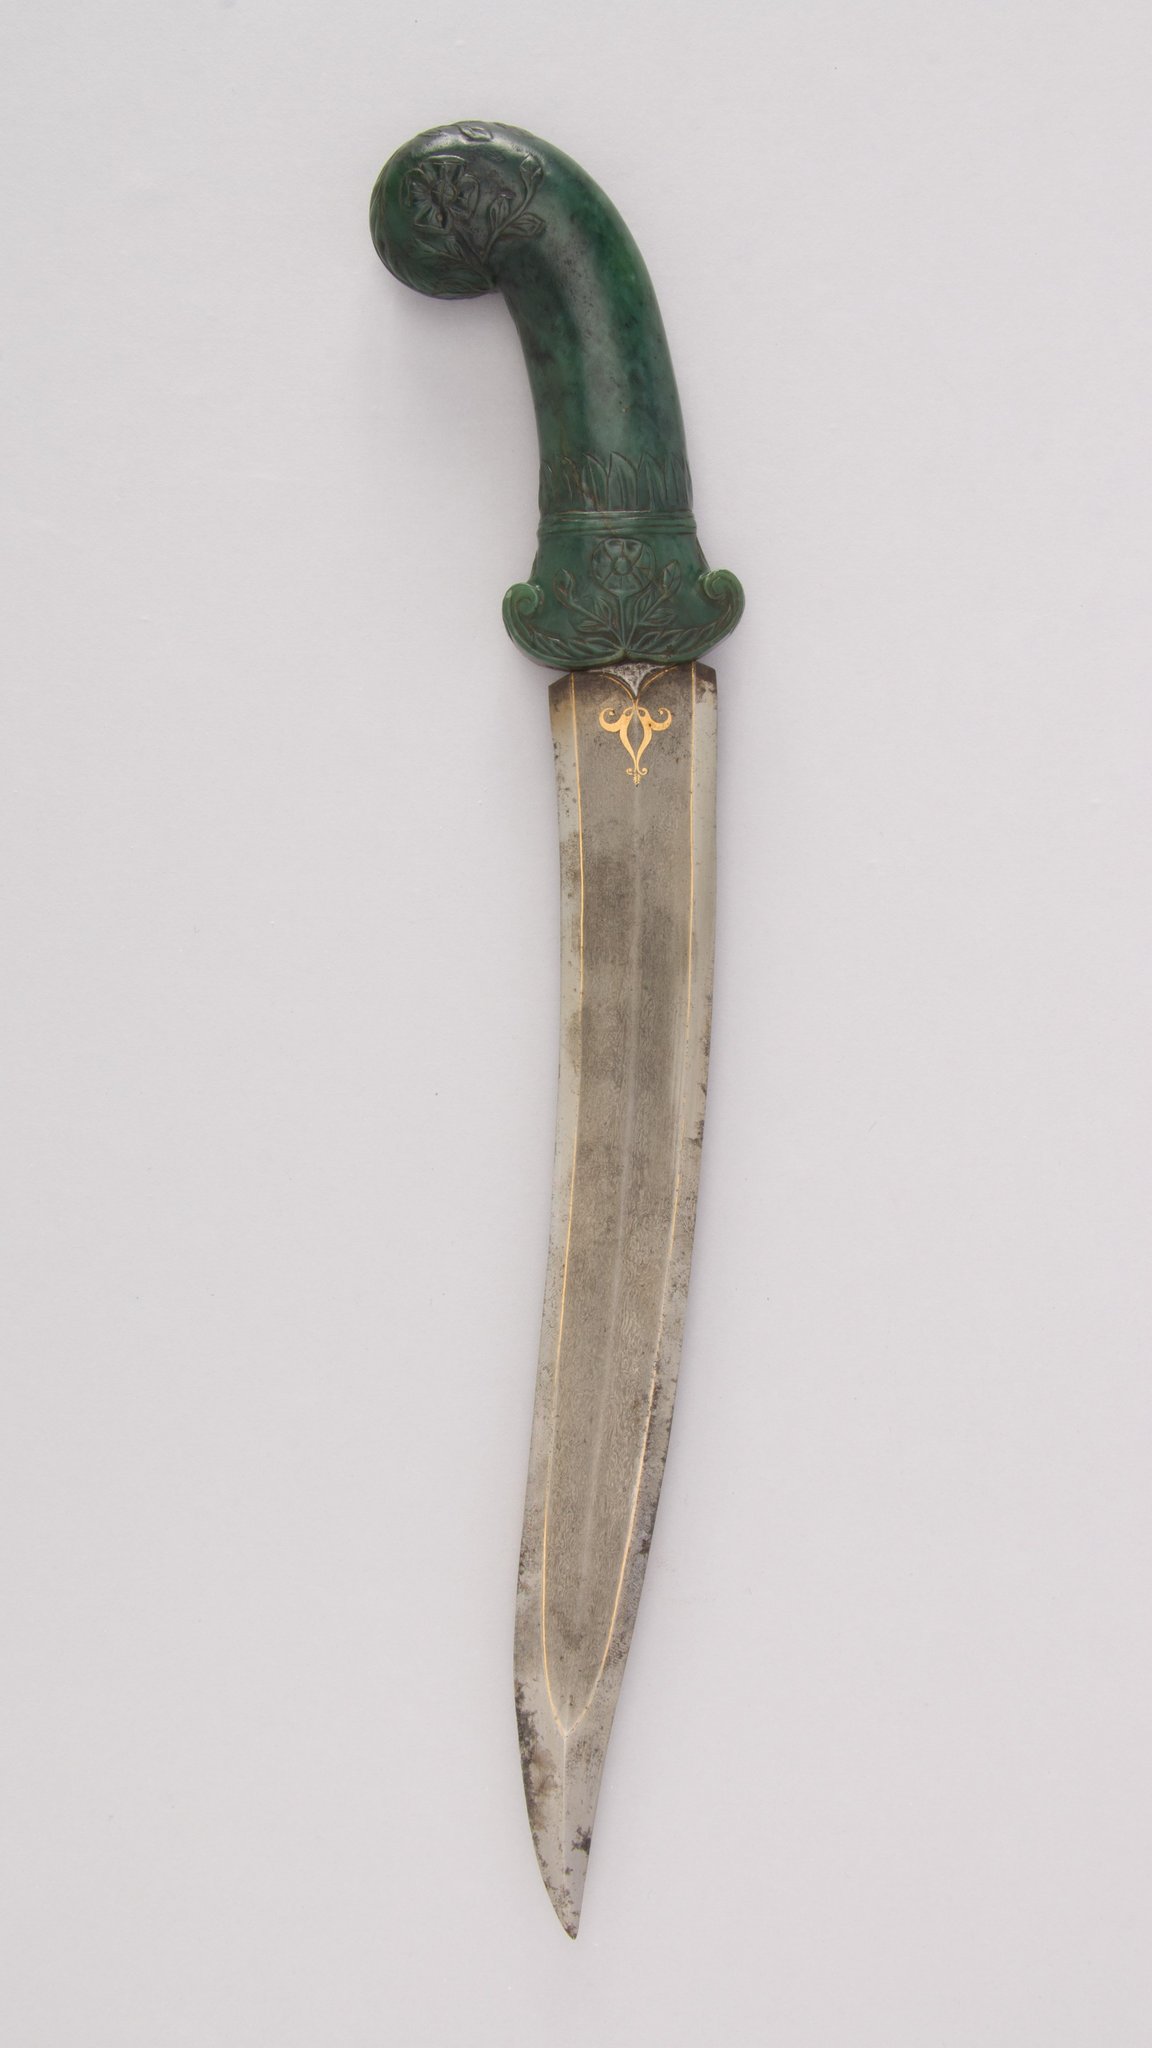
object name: dagger khanjar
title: Dagger (Khanjar)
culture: indian, mughal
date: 1701-1900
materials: gold, jade, silver, steel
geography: india